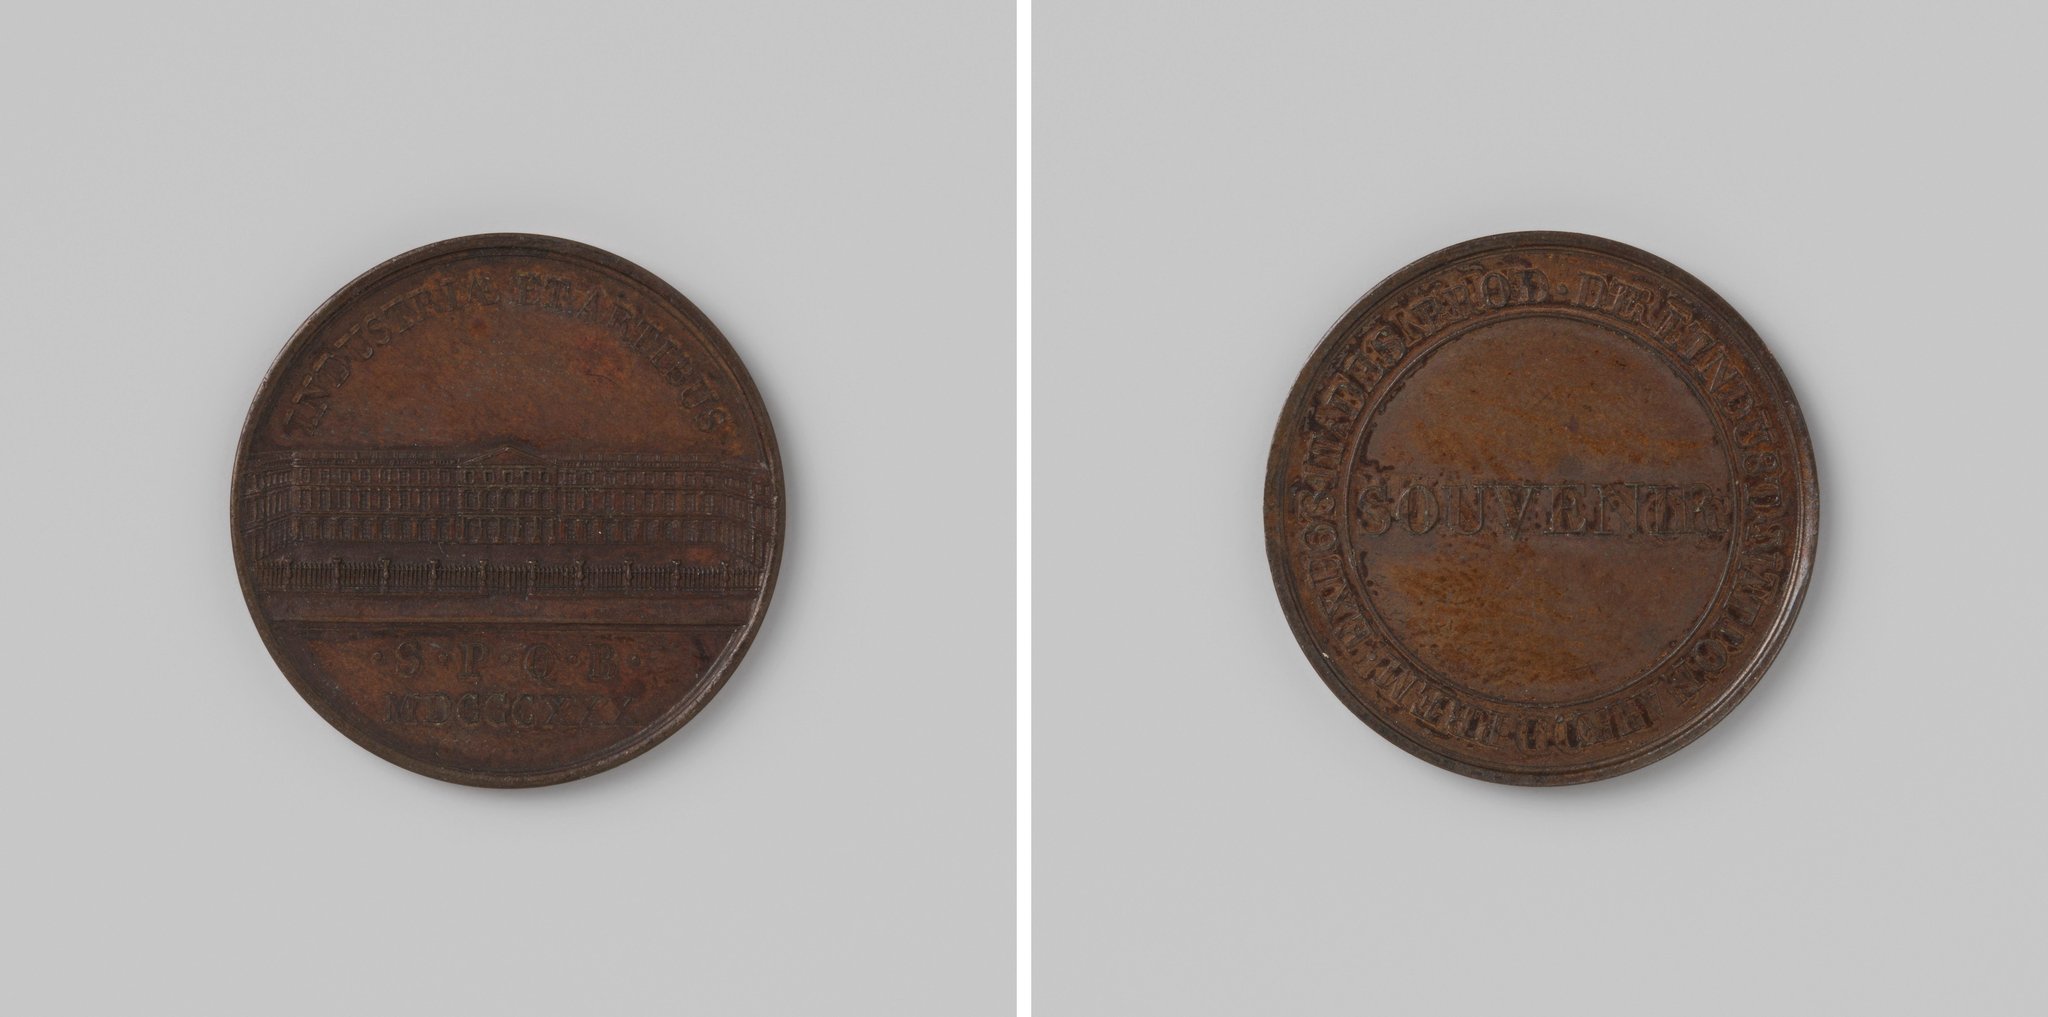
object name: jeton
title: Tentoonstelling van Nijverheid te Brussel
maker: joseph pierre braemt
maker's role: print maker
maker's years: 1796-1864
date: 1830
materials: bronze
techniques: striking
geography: brussels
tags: paleis voor nijverheid en industrie, nationale nijverheidstentoonstelling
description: Bronzen penning. Voorzijde: paleis van Nijverheid en Industrie binnen omschrift; afsnede: opschrift. Keerzijde: opschrift binnen omschrift